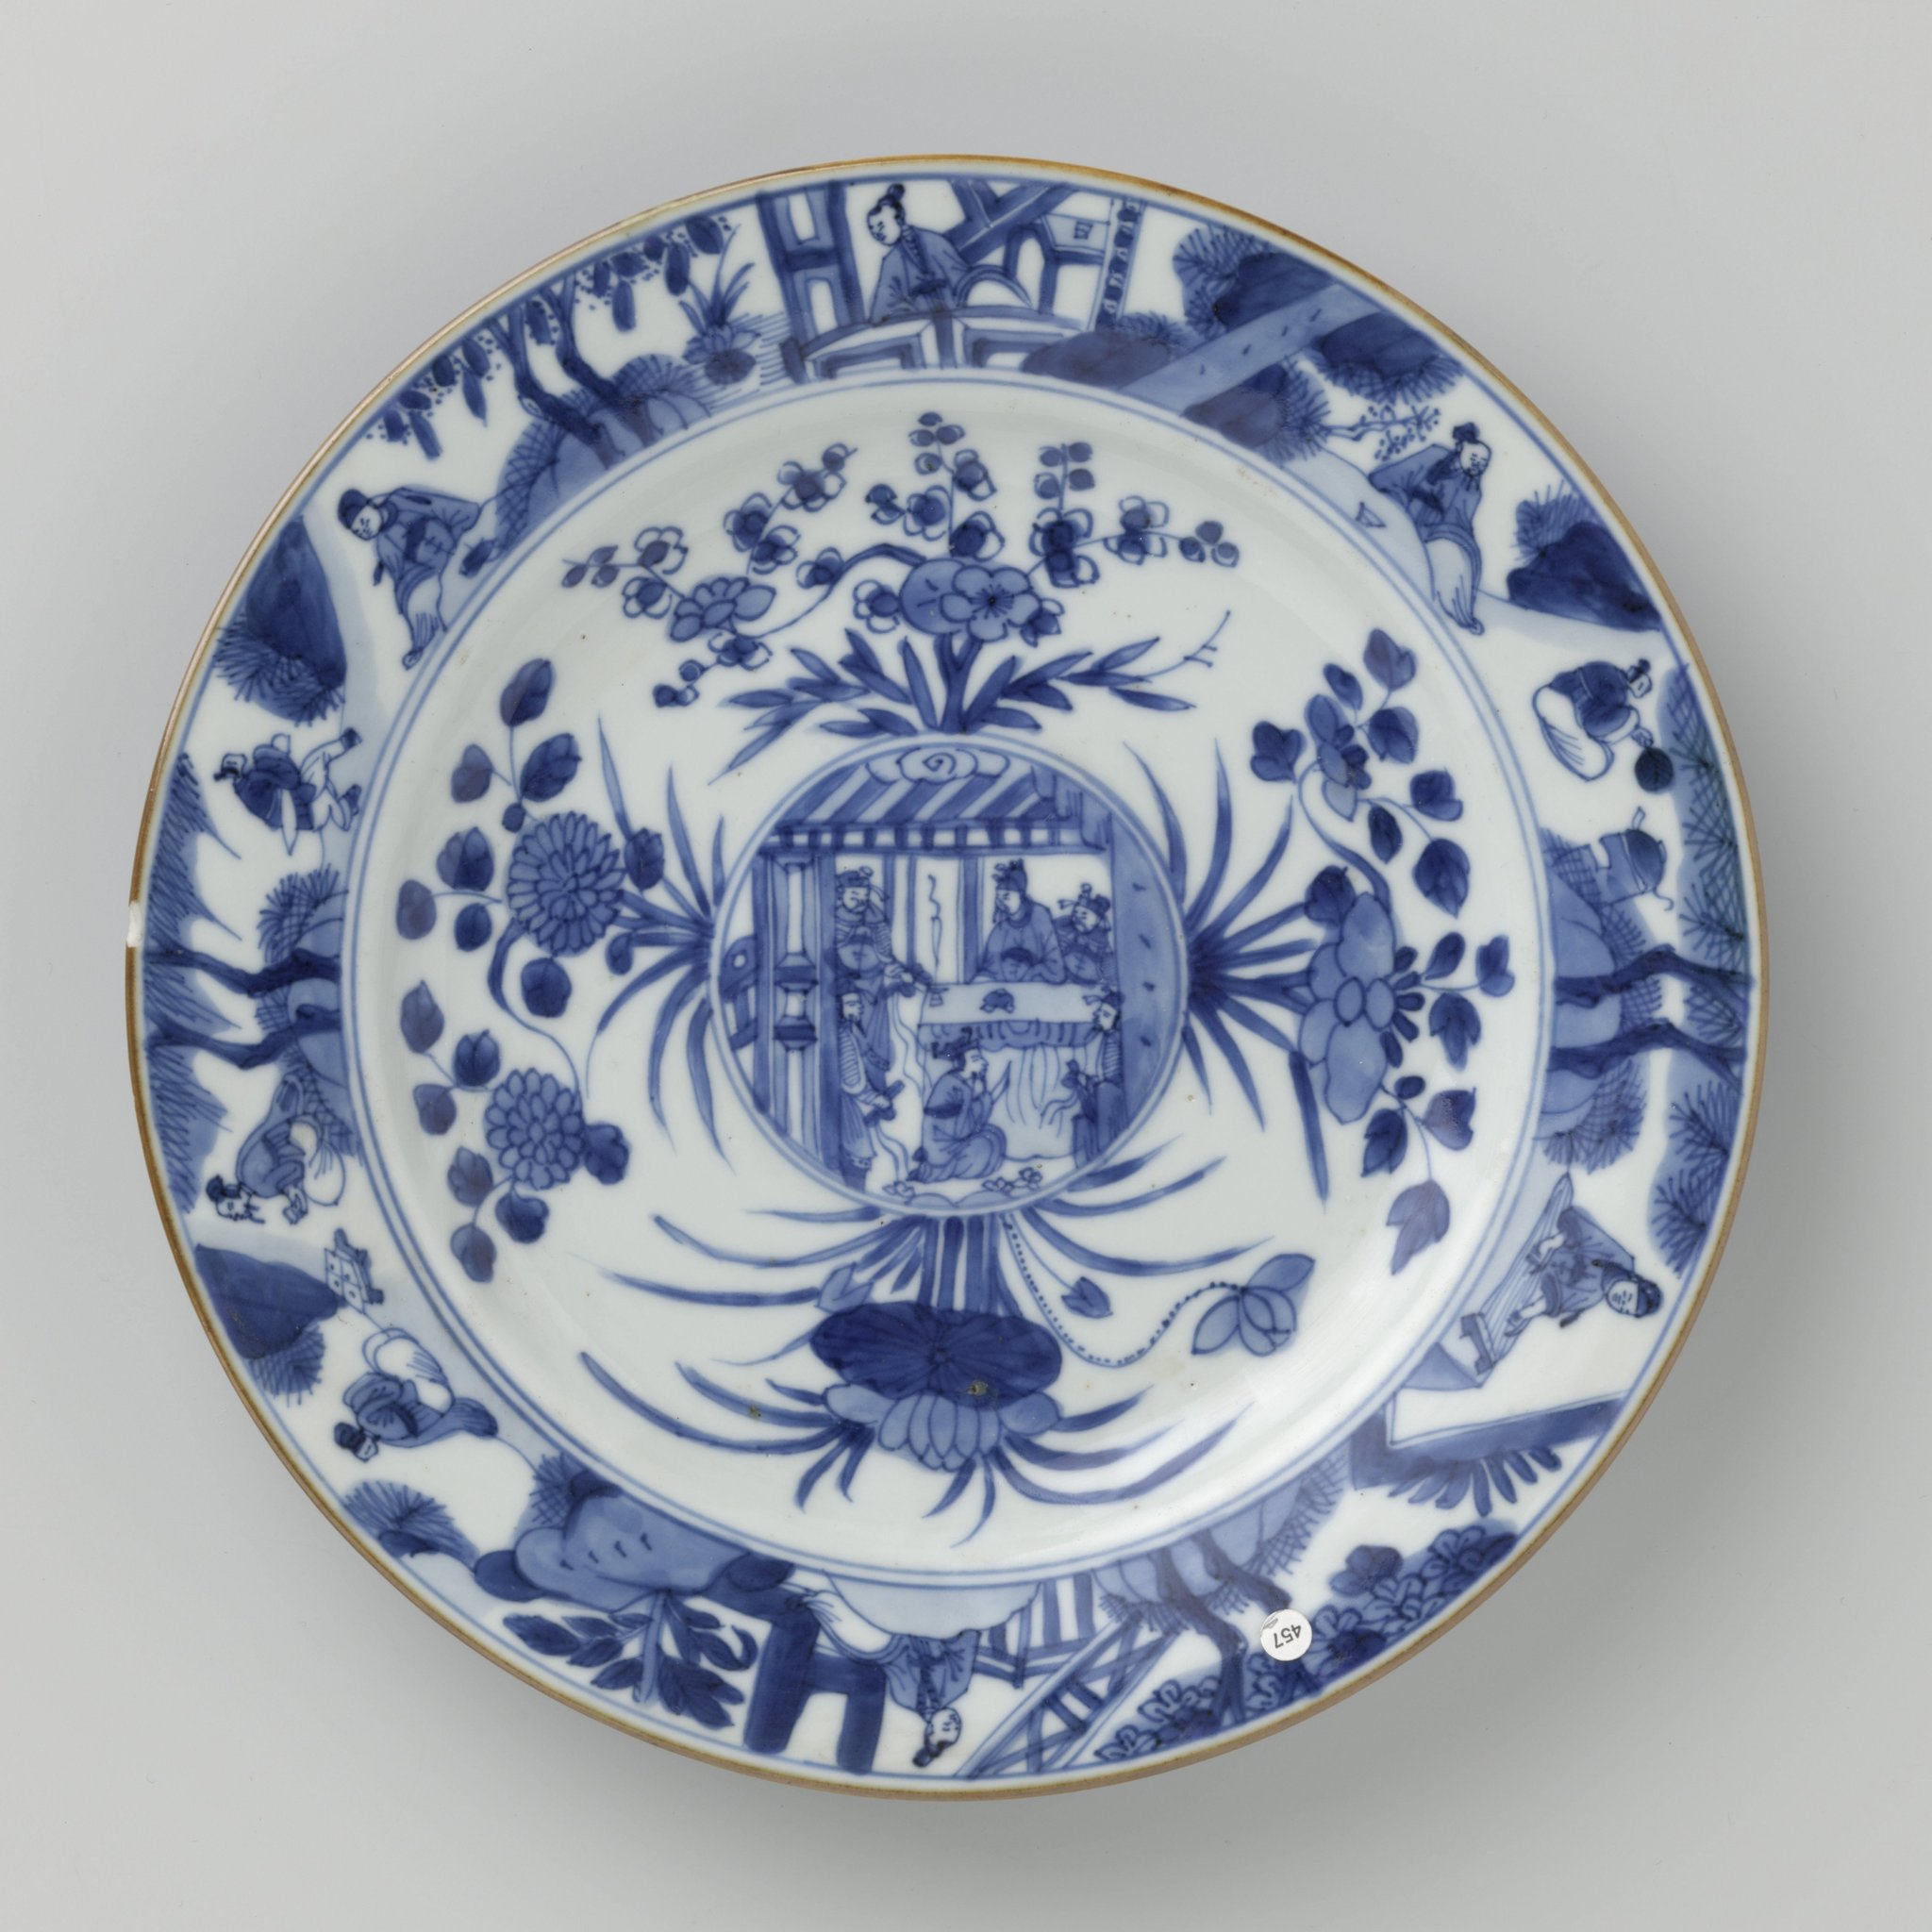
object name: plate dish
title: Plate with flower sprays and figures in an interior and in a landscape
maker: Anonymous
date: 1700-1724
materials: cobalt, glaze, paint, porcelain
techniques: firing, turning, vitrification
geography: china